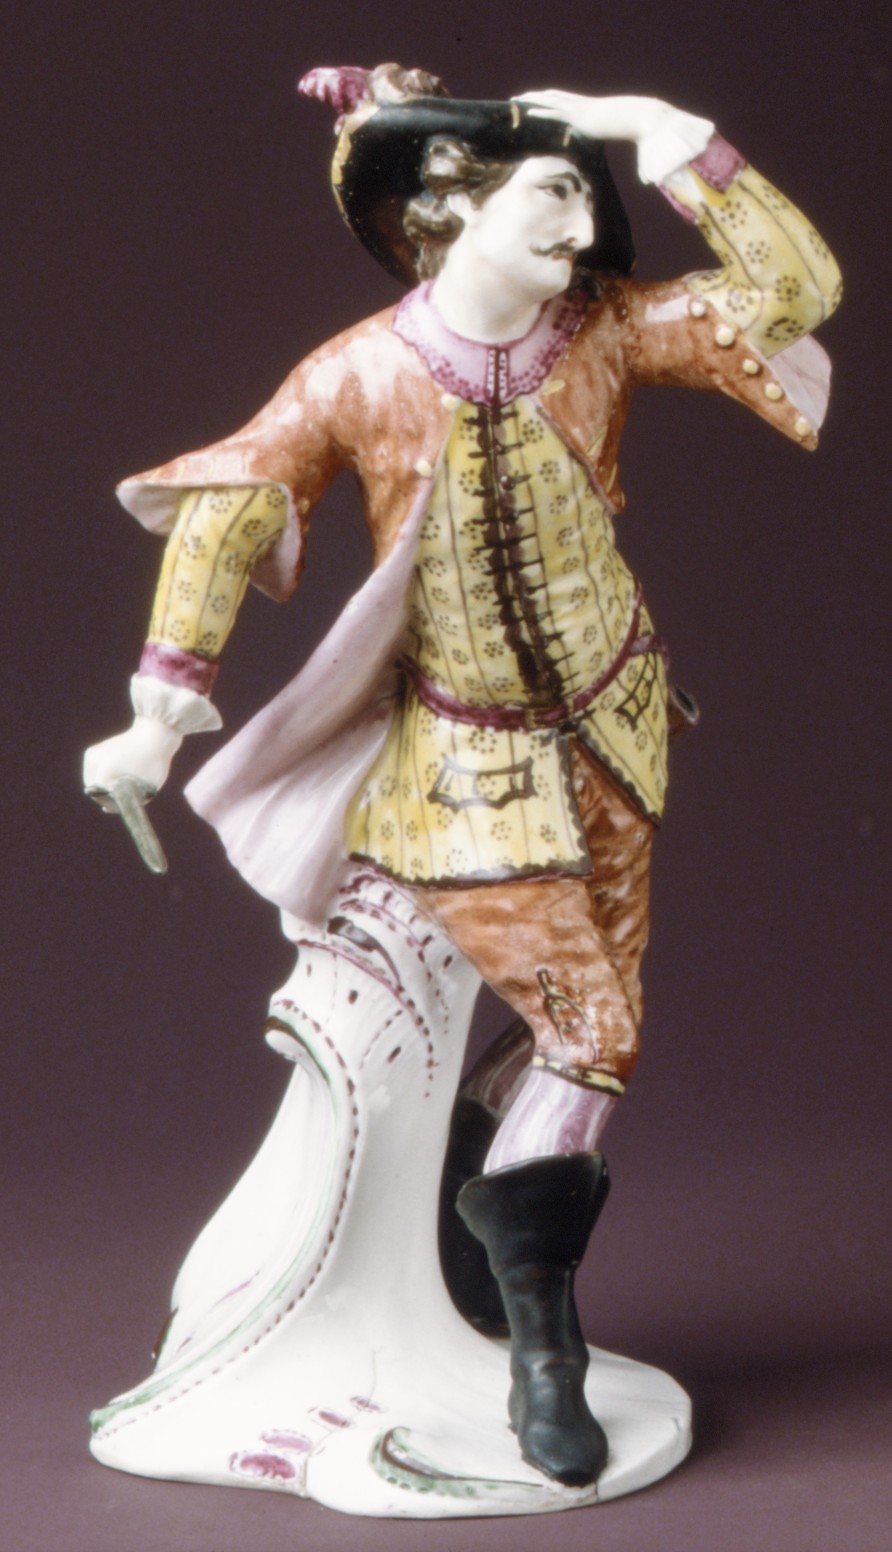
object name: figure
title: Captain Spavento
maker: nymphenburg porcelain manufactory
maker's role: manufactory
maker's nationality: german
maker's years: 1747-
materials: hard paste porcelain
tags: men